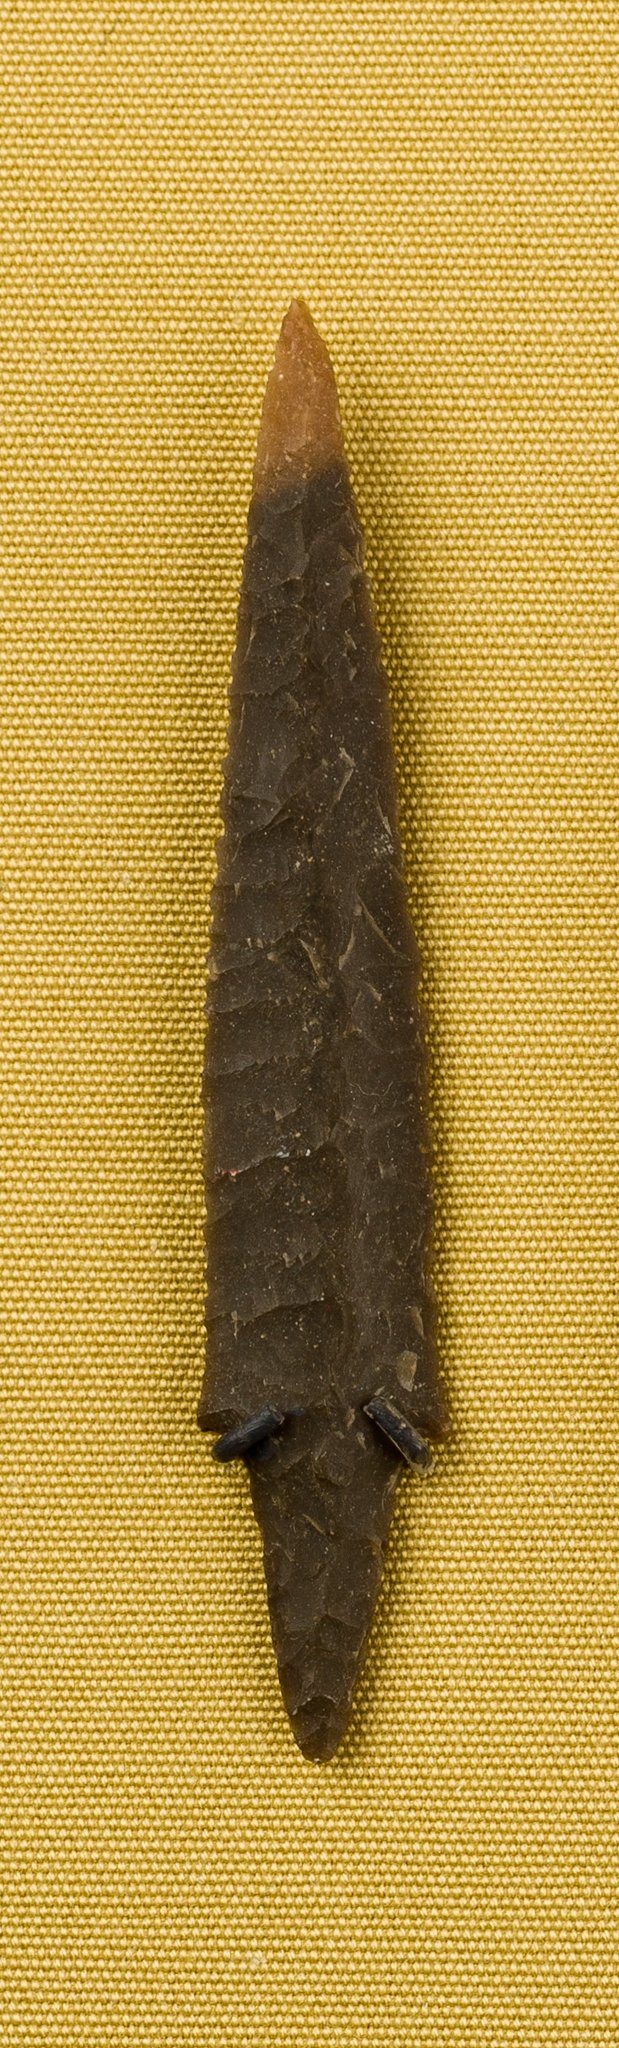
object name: arrowhead, projectile point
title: Projectile Point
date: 3100-2900 BCE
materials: stone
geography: egypt